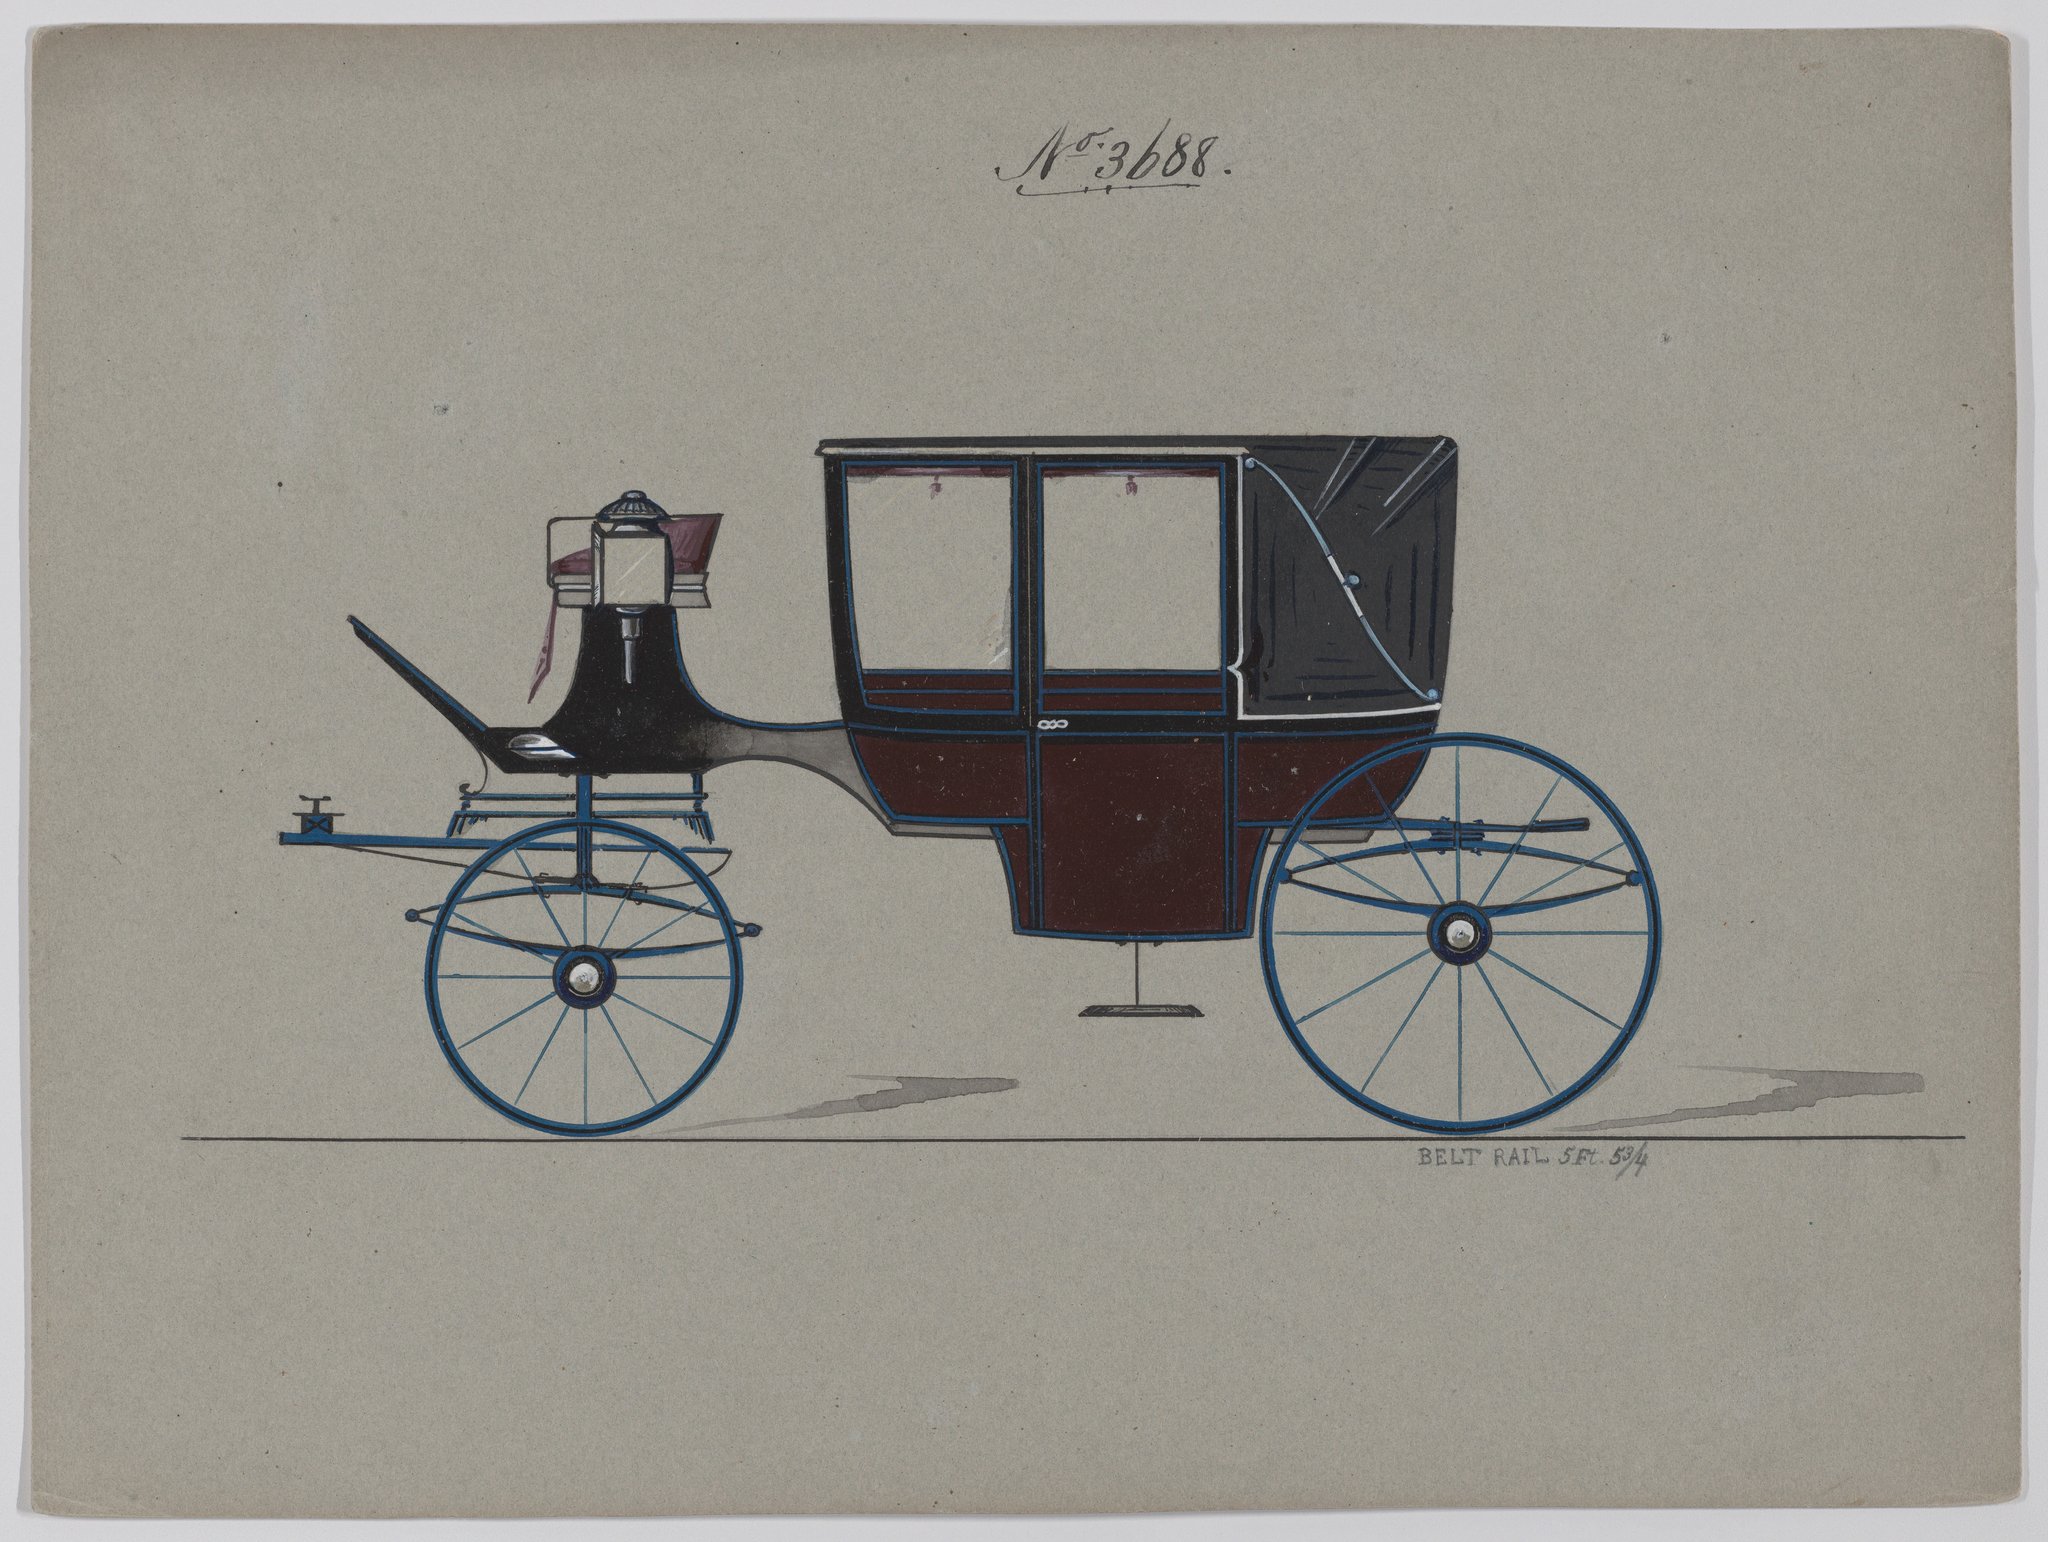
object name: drawing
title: Design for Landau, No. 3688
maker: brewster & co.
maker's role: manufacturer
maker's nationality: american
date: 1881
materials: gouache, gum arabic, ink, watercolor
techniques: pen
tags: carriages